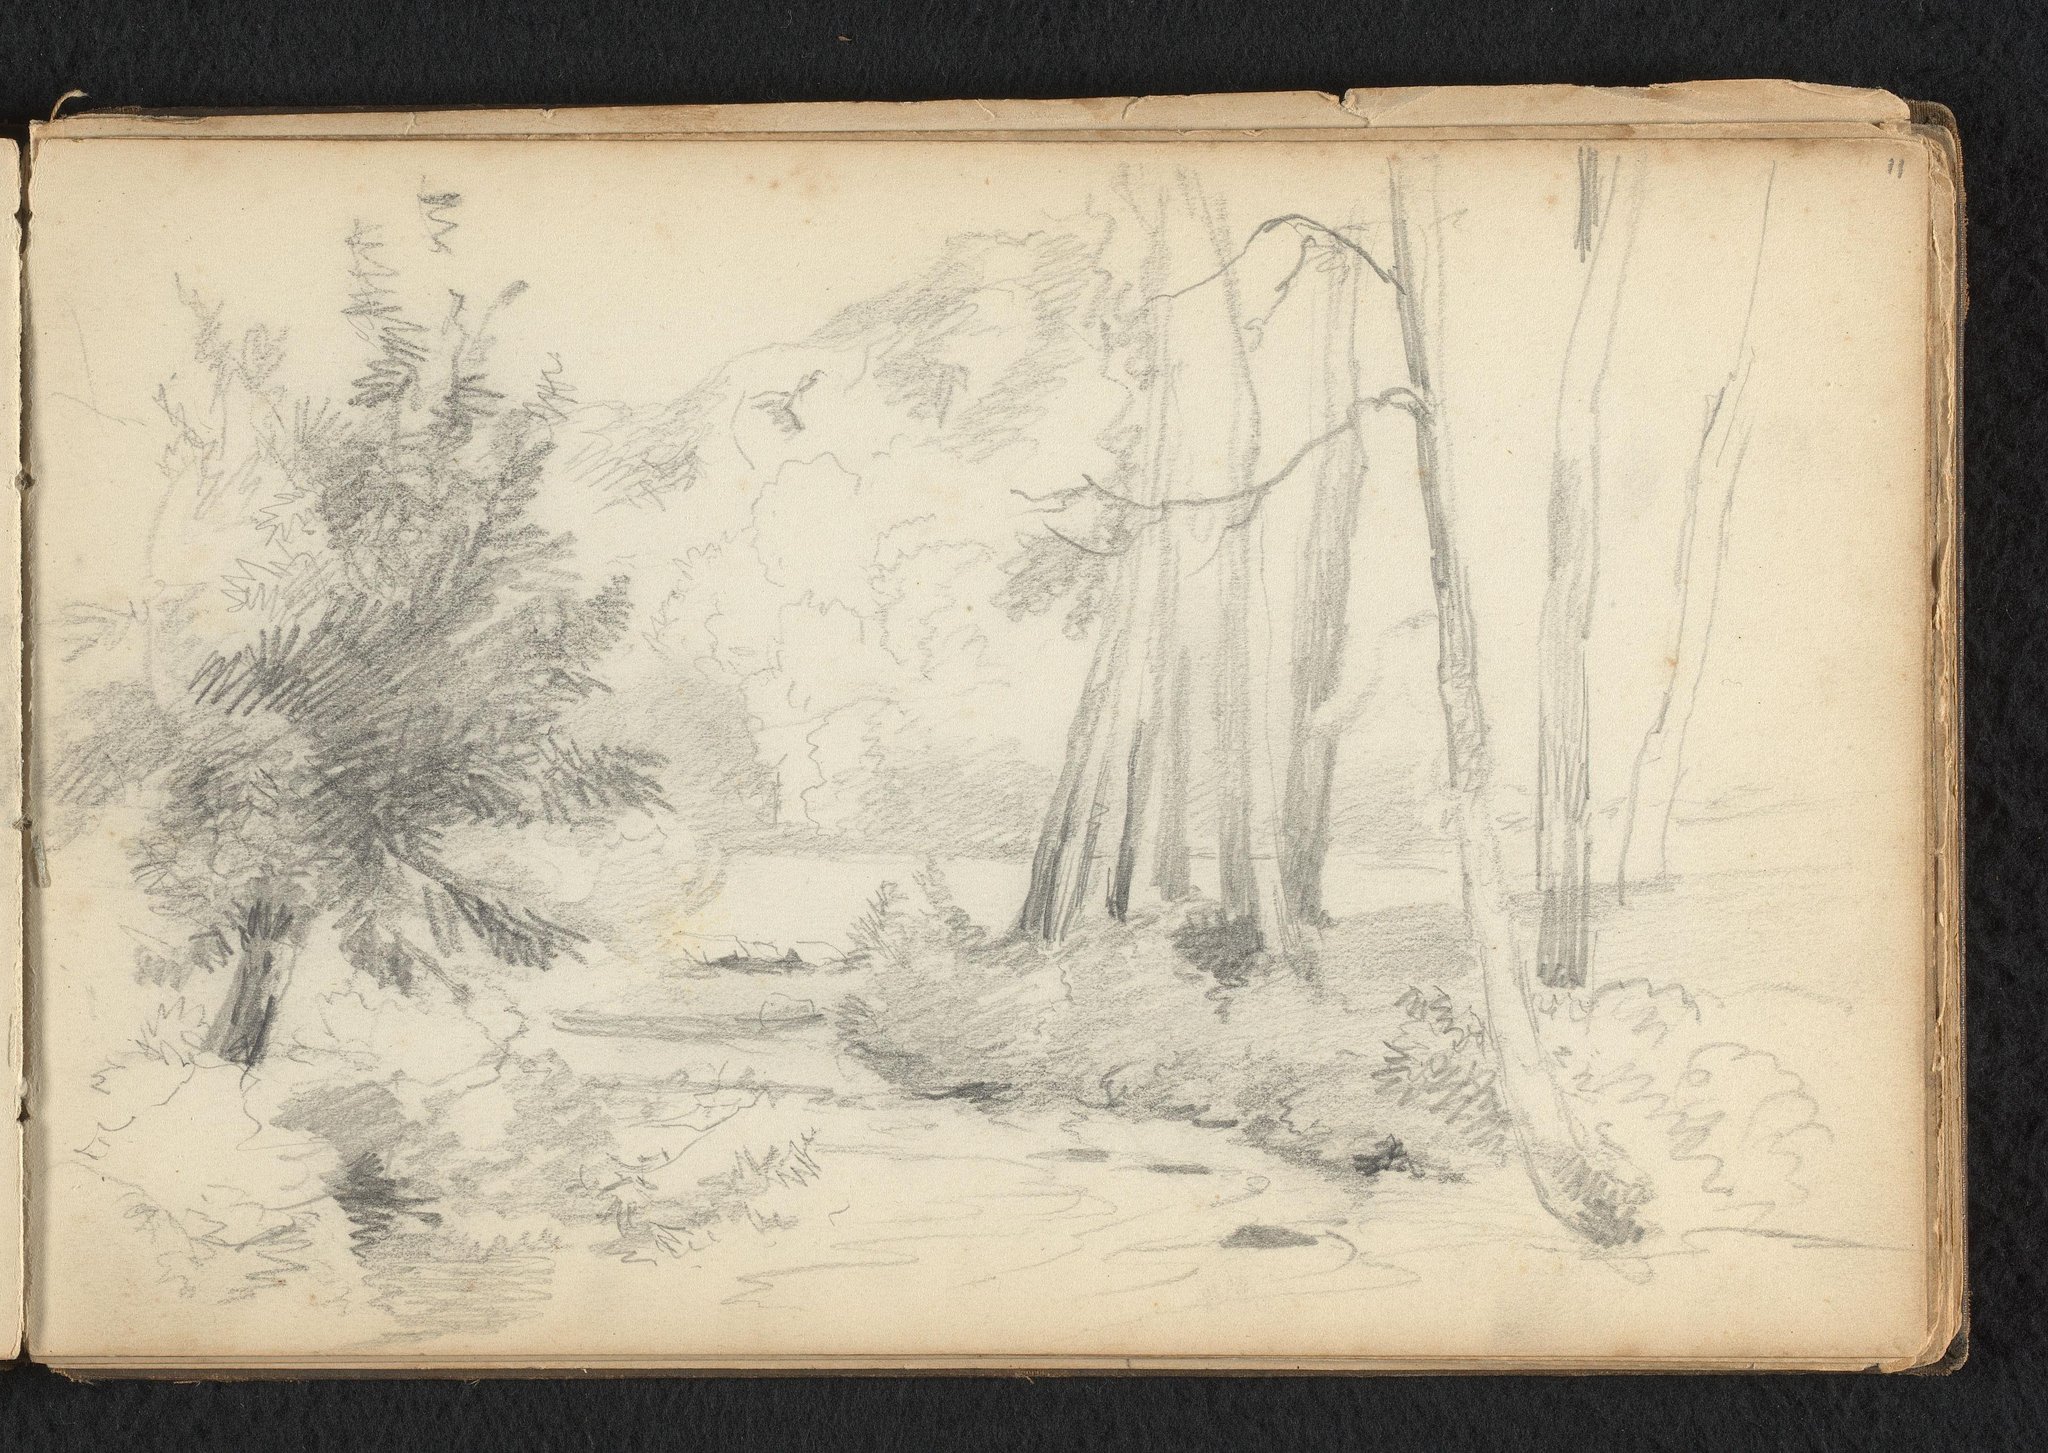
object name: sketchbook leaf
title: Bospad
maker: jan bedijs tom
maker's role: draughtsman, painter, print maker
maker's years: 1813-1894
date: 1823-1894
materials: paper, pencil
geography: the hague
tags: forest path or lane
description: Pagina 11 recto uit een schetsboek met 37 bladen.